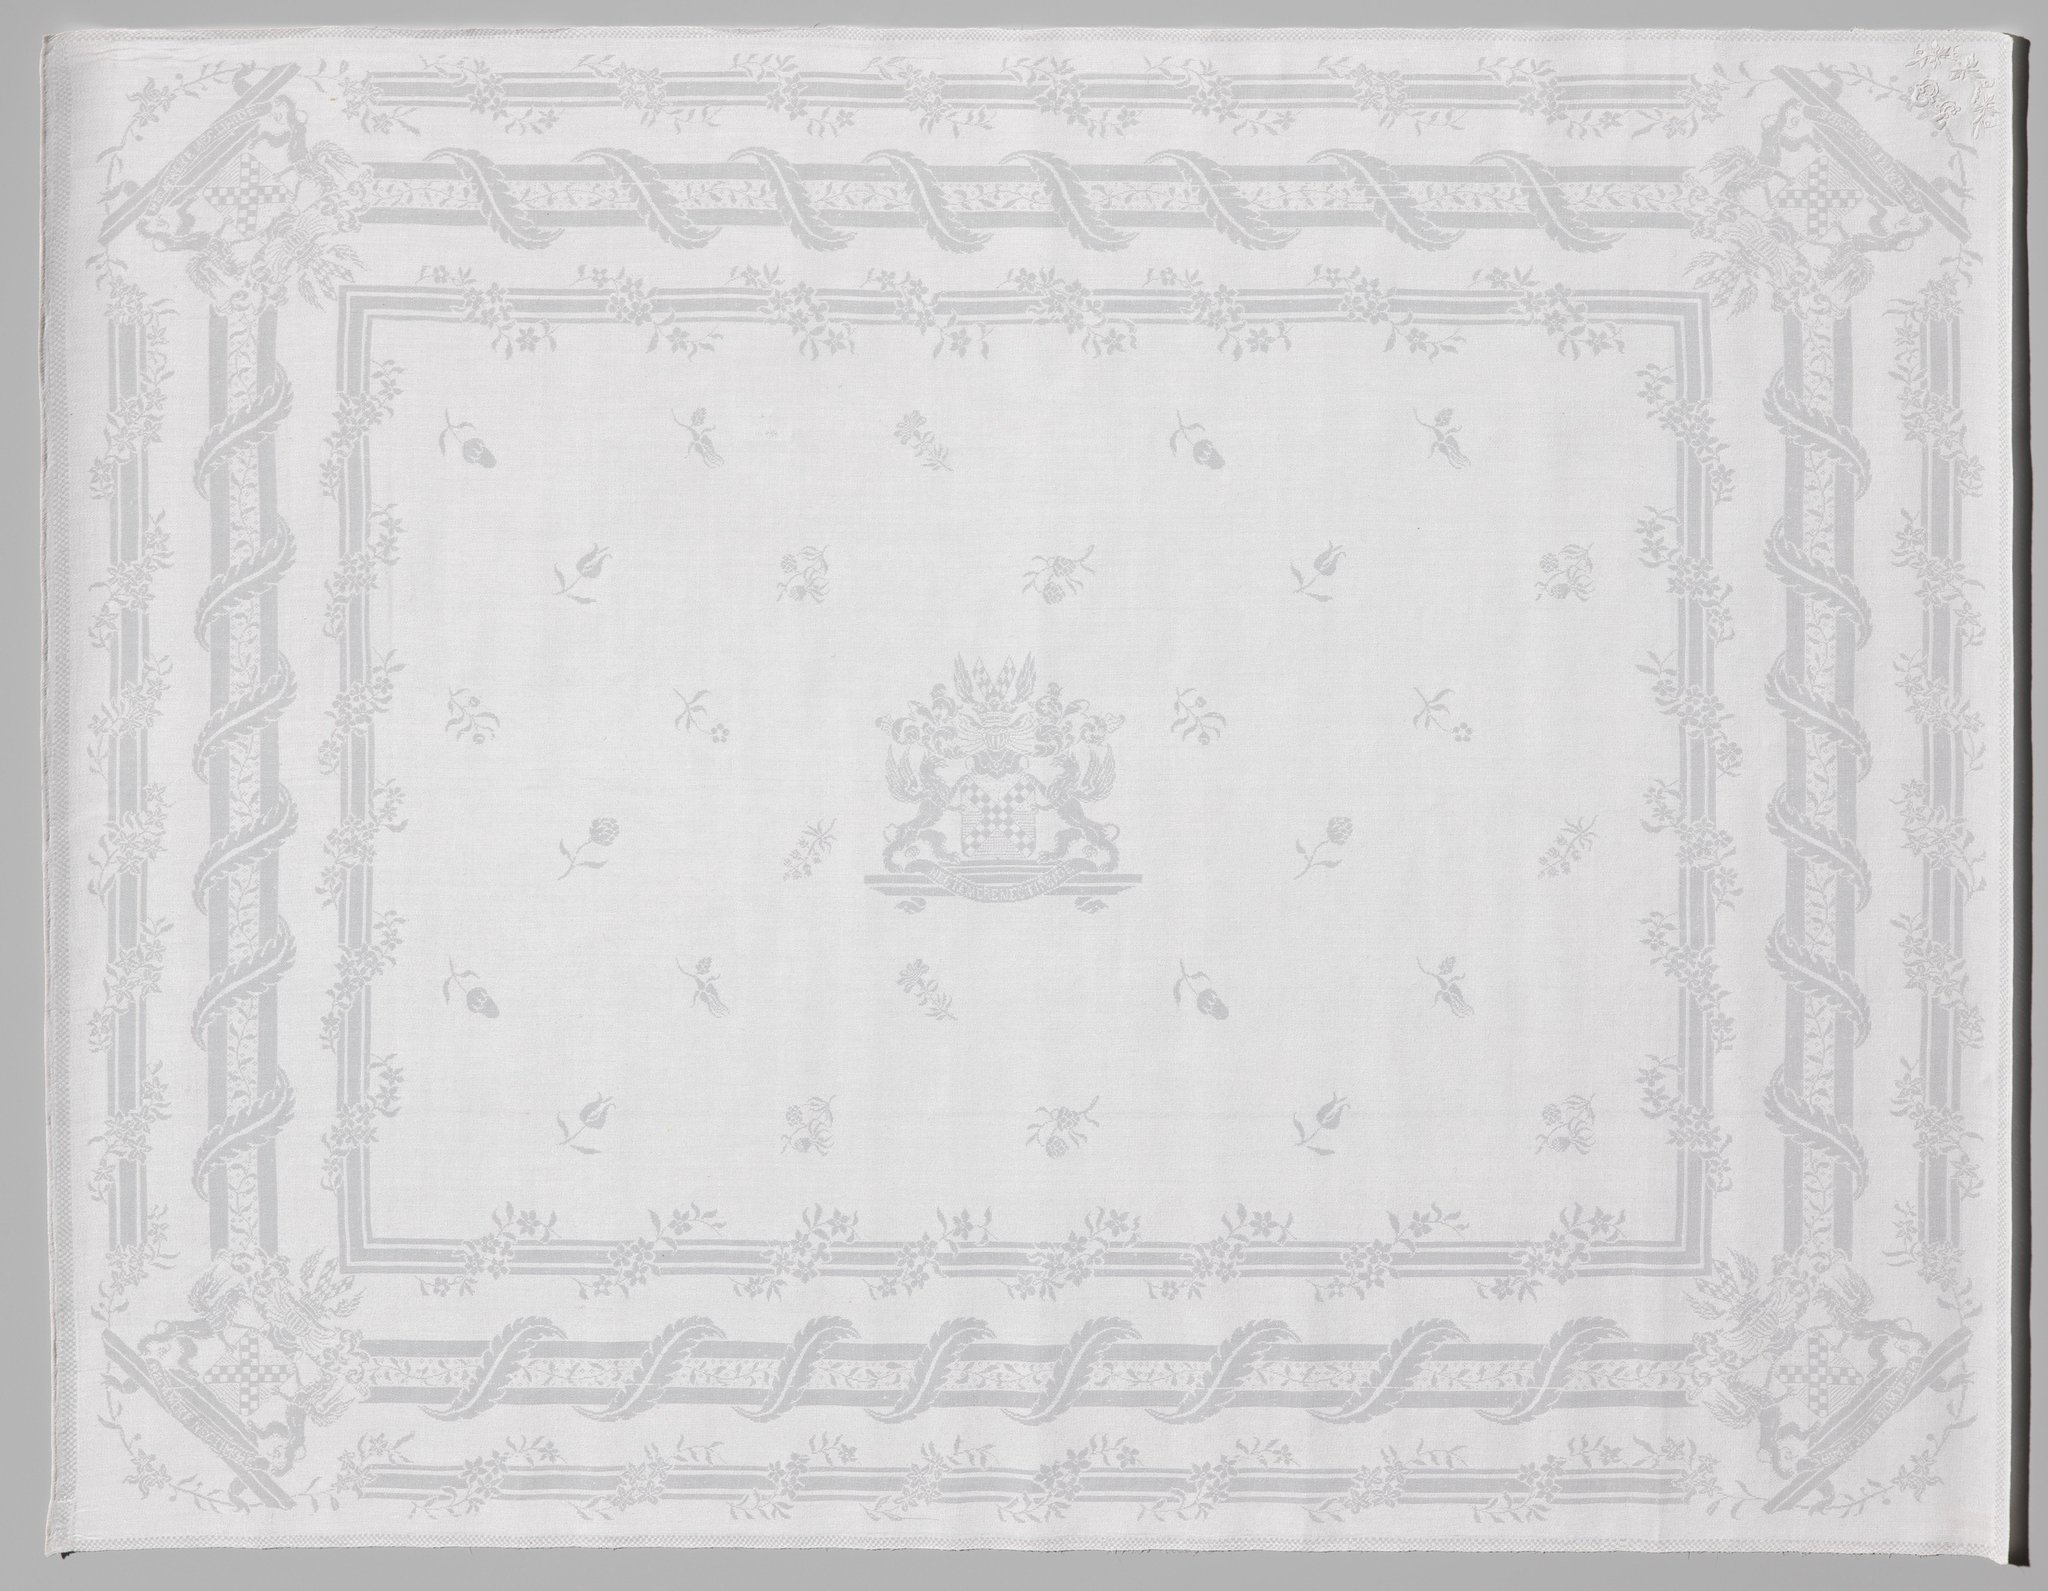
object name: napkin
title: Servet met het familiewapen Van der Dussen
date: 1870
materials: linen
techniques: damask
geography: boxtel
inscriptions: mark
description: Servet van linnendamast met het familiewapen Van der Dussen. Middenveld: wapenschild temidden van gestrooide bloemknoppen. Randen: drie drievoudige banden, de middelste met een bladrank, de andere glad en omslingerd met een spiraaltak.